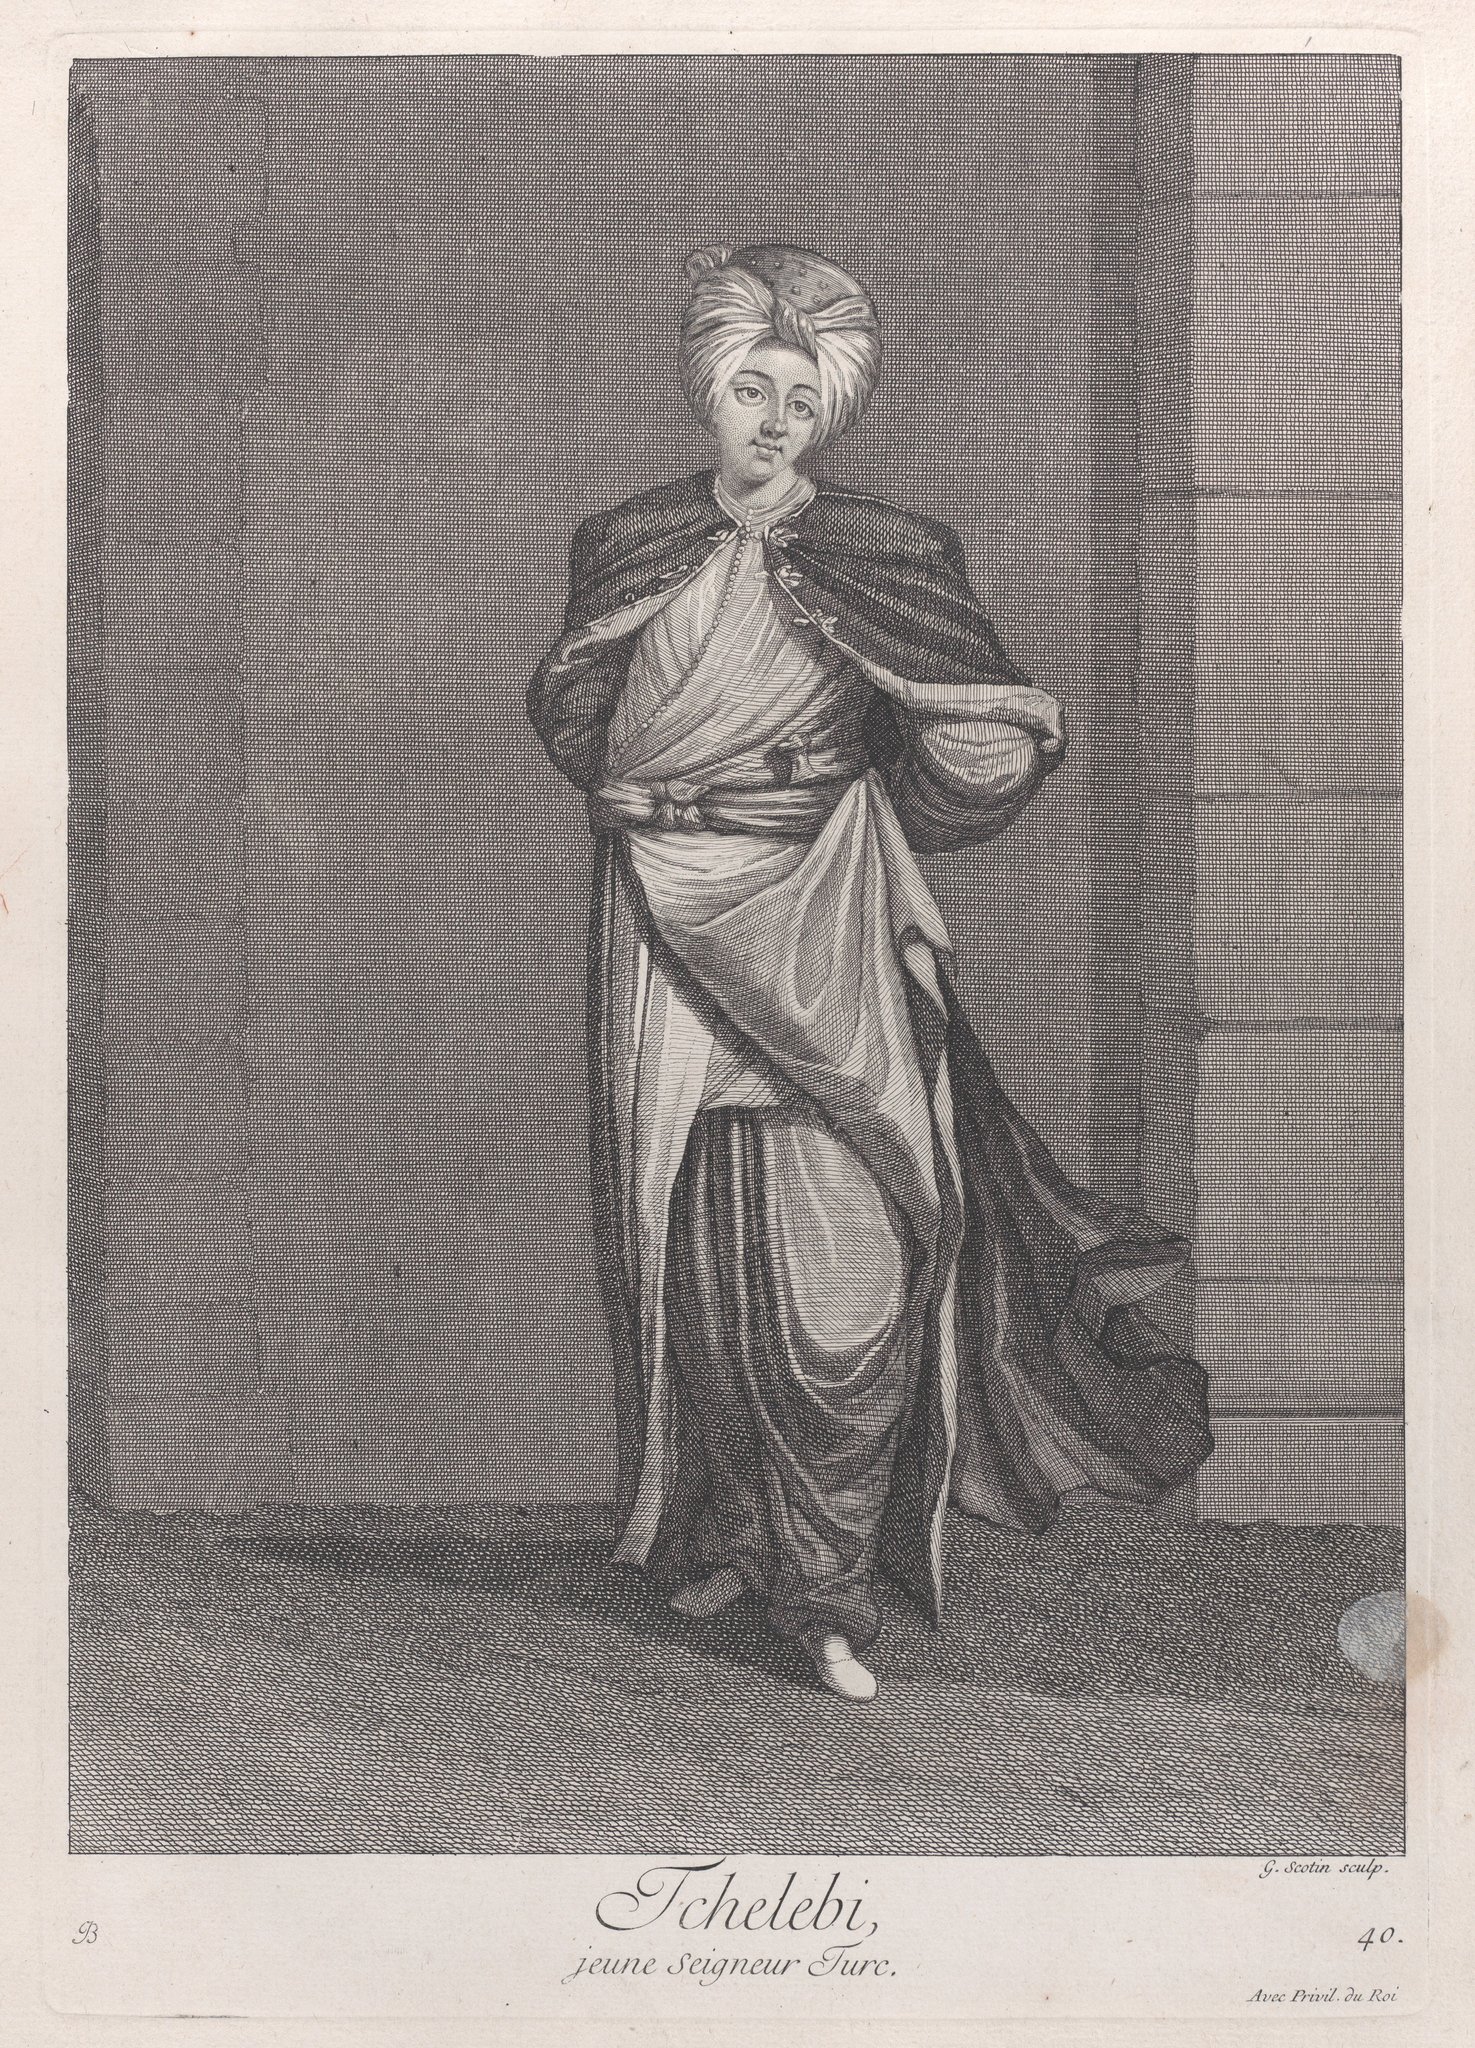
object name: print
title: Tchelebi, jeune seigneur Turc, plate 40 from "Recueil de cent estampes représentent differentes nations du Levant"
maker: jean baptiste vanmour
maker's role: artist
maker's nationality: french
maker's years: 1671-1737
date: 1714-1715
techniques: engraving, etching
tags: men